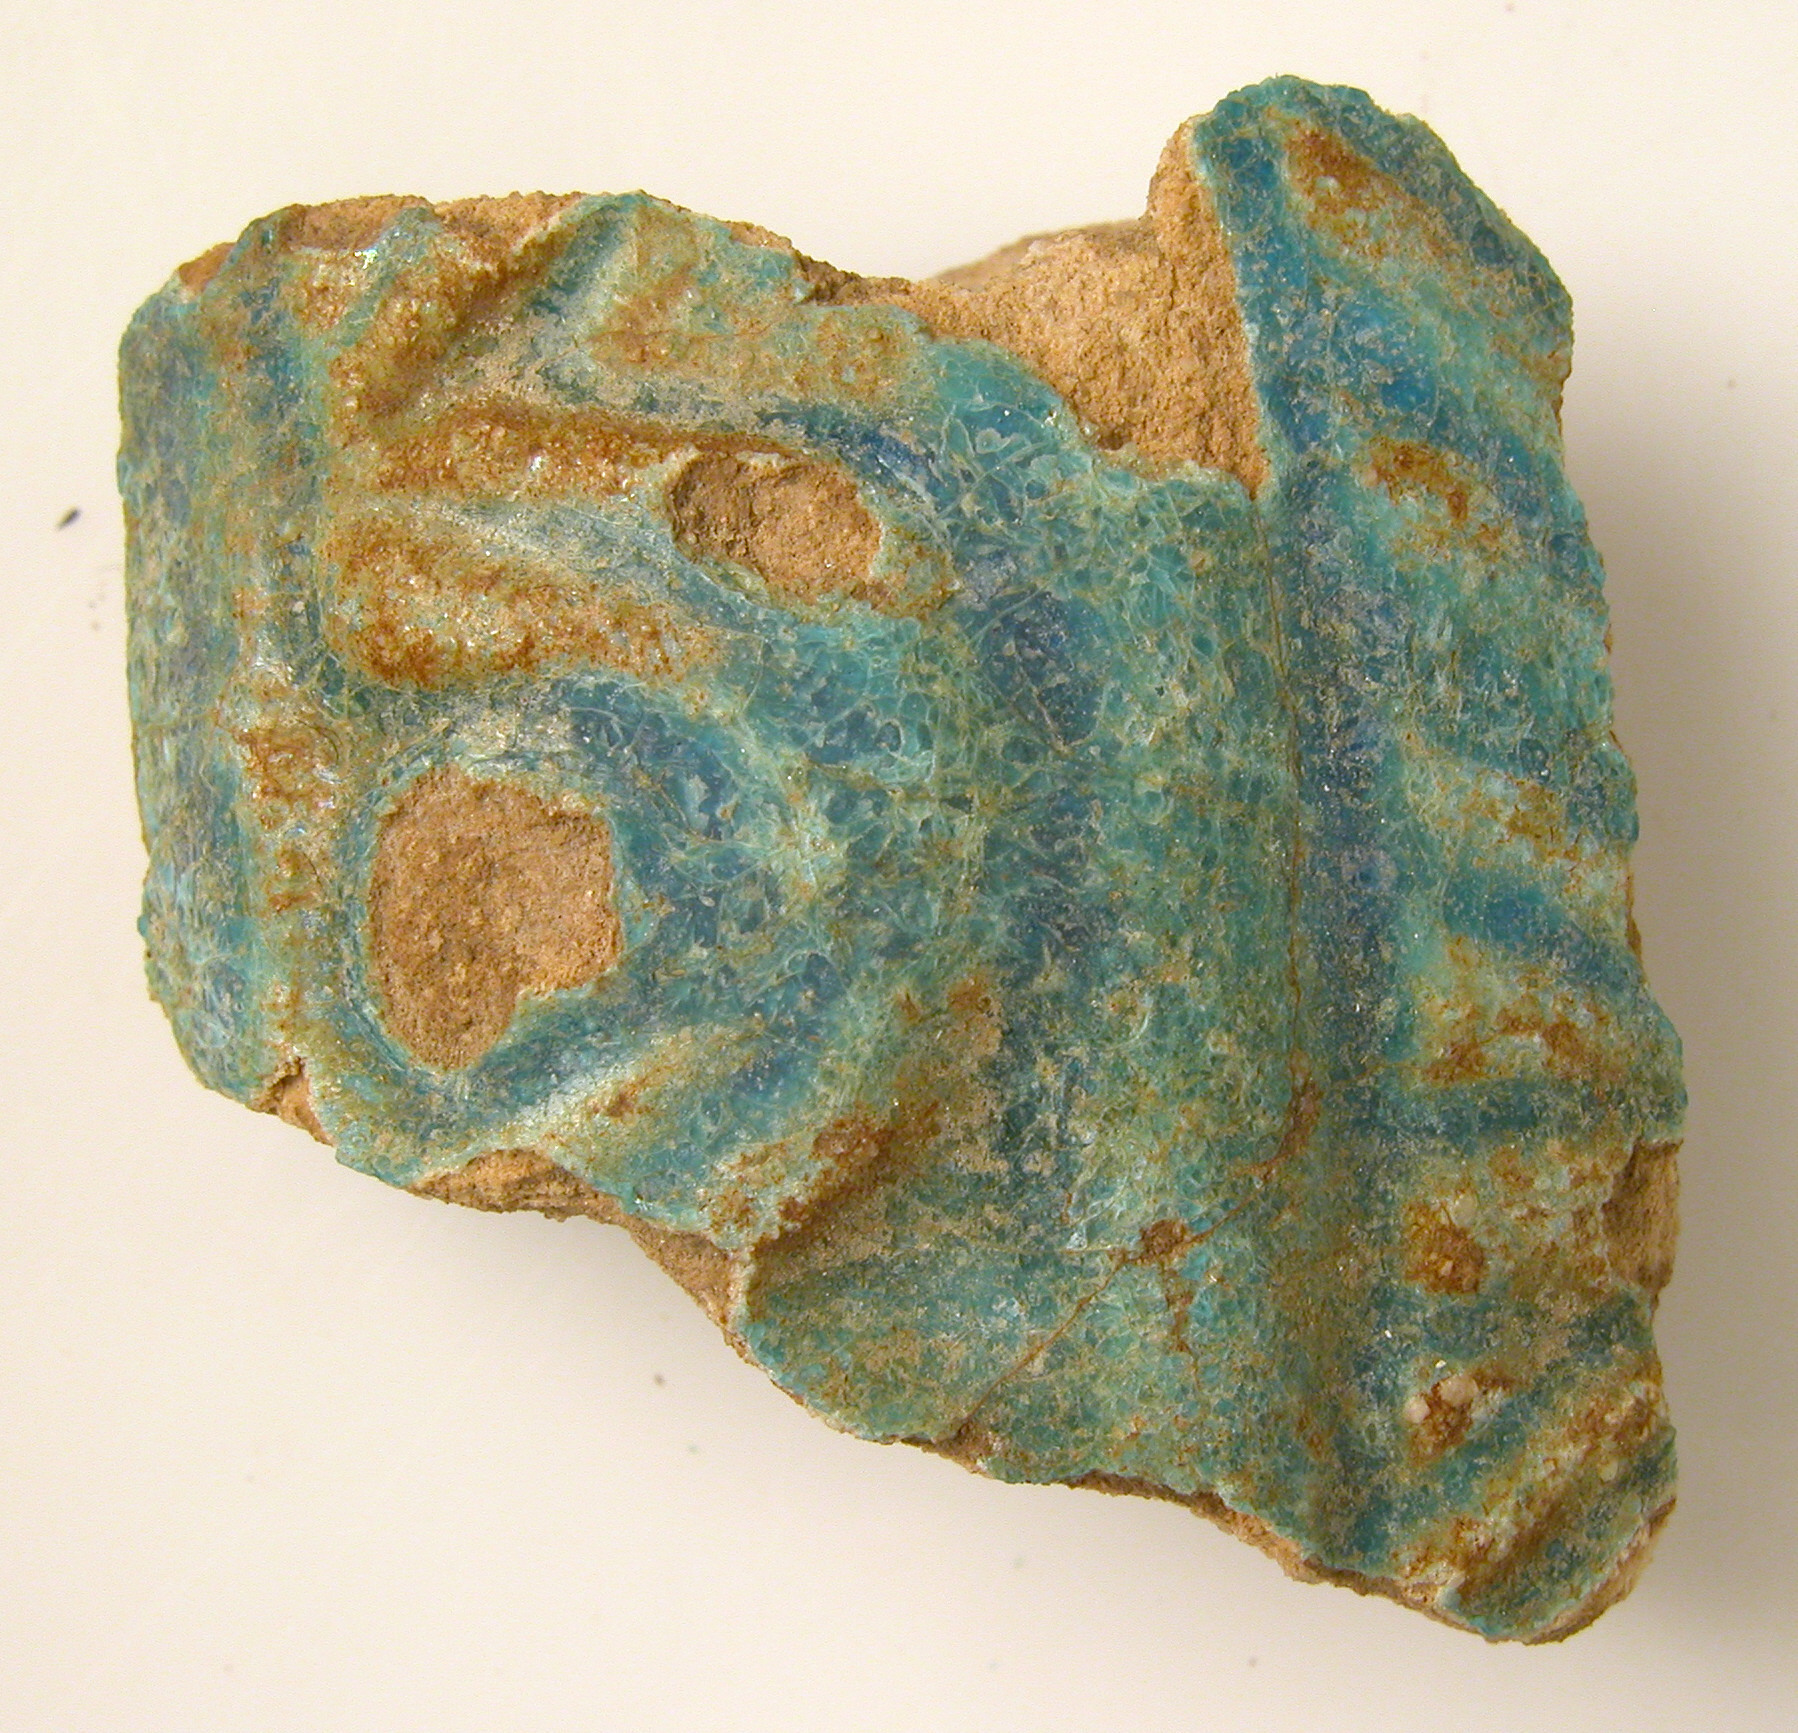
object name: fragment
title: Pottery Fragment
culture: coptic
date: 301-700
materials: earthenware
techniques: glazing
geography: egypt